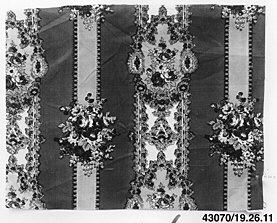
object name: sample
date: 1840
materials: cotton